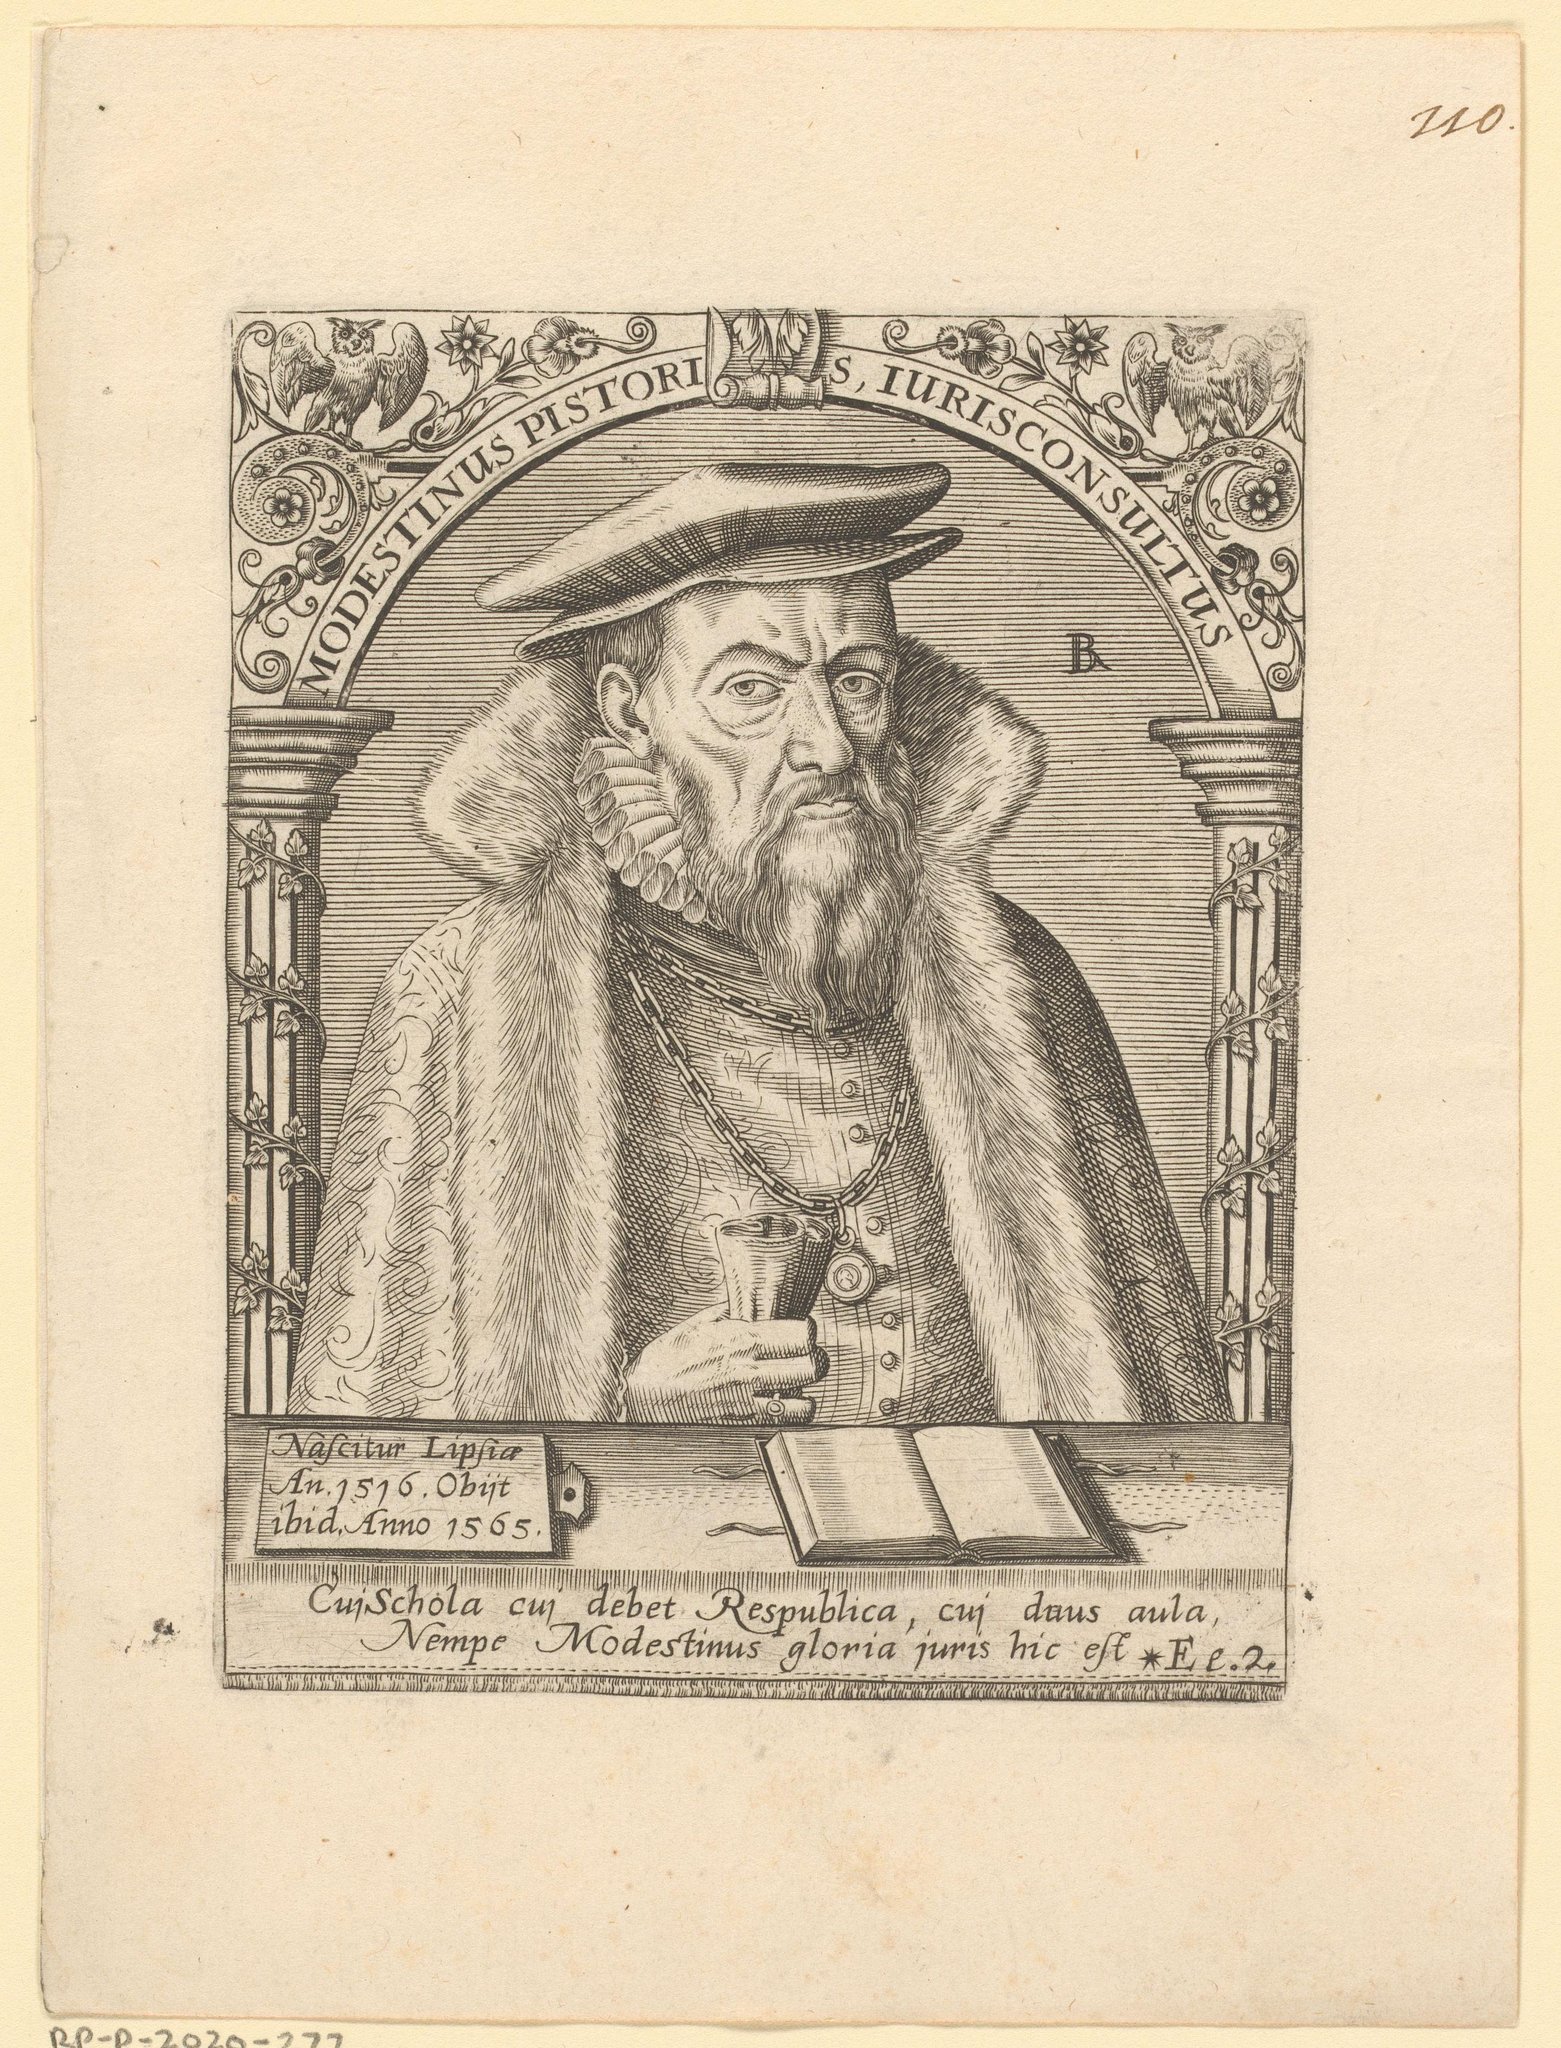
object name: print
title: Portret van Modestinus Pistoris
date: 1650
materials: paper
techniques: engraving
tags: mayor, mayor, burgomaster, historical persons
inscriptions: inscription: ‘110.’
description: Prent gebruikt in: Boissard, Jean Jacques. Bibliotheca chalcographica. 8 dln. Frankfurt am Main: Johannes Ammon, 1650-1652. Ook gebruikt in latere edities. Eerdere staat van prent verschenen in: Boissard, Jean Jacques. Icones quinquaginta virorum illustrium doctrina & eruditione praestantium ad vivum effictae. 4 dln. Frankfurt am Main: s.n., 1597-1599. Mogelijk ook gebruikt in latere edities.